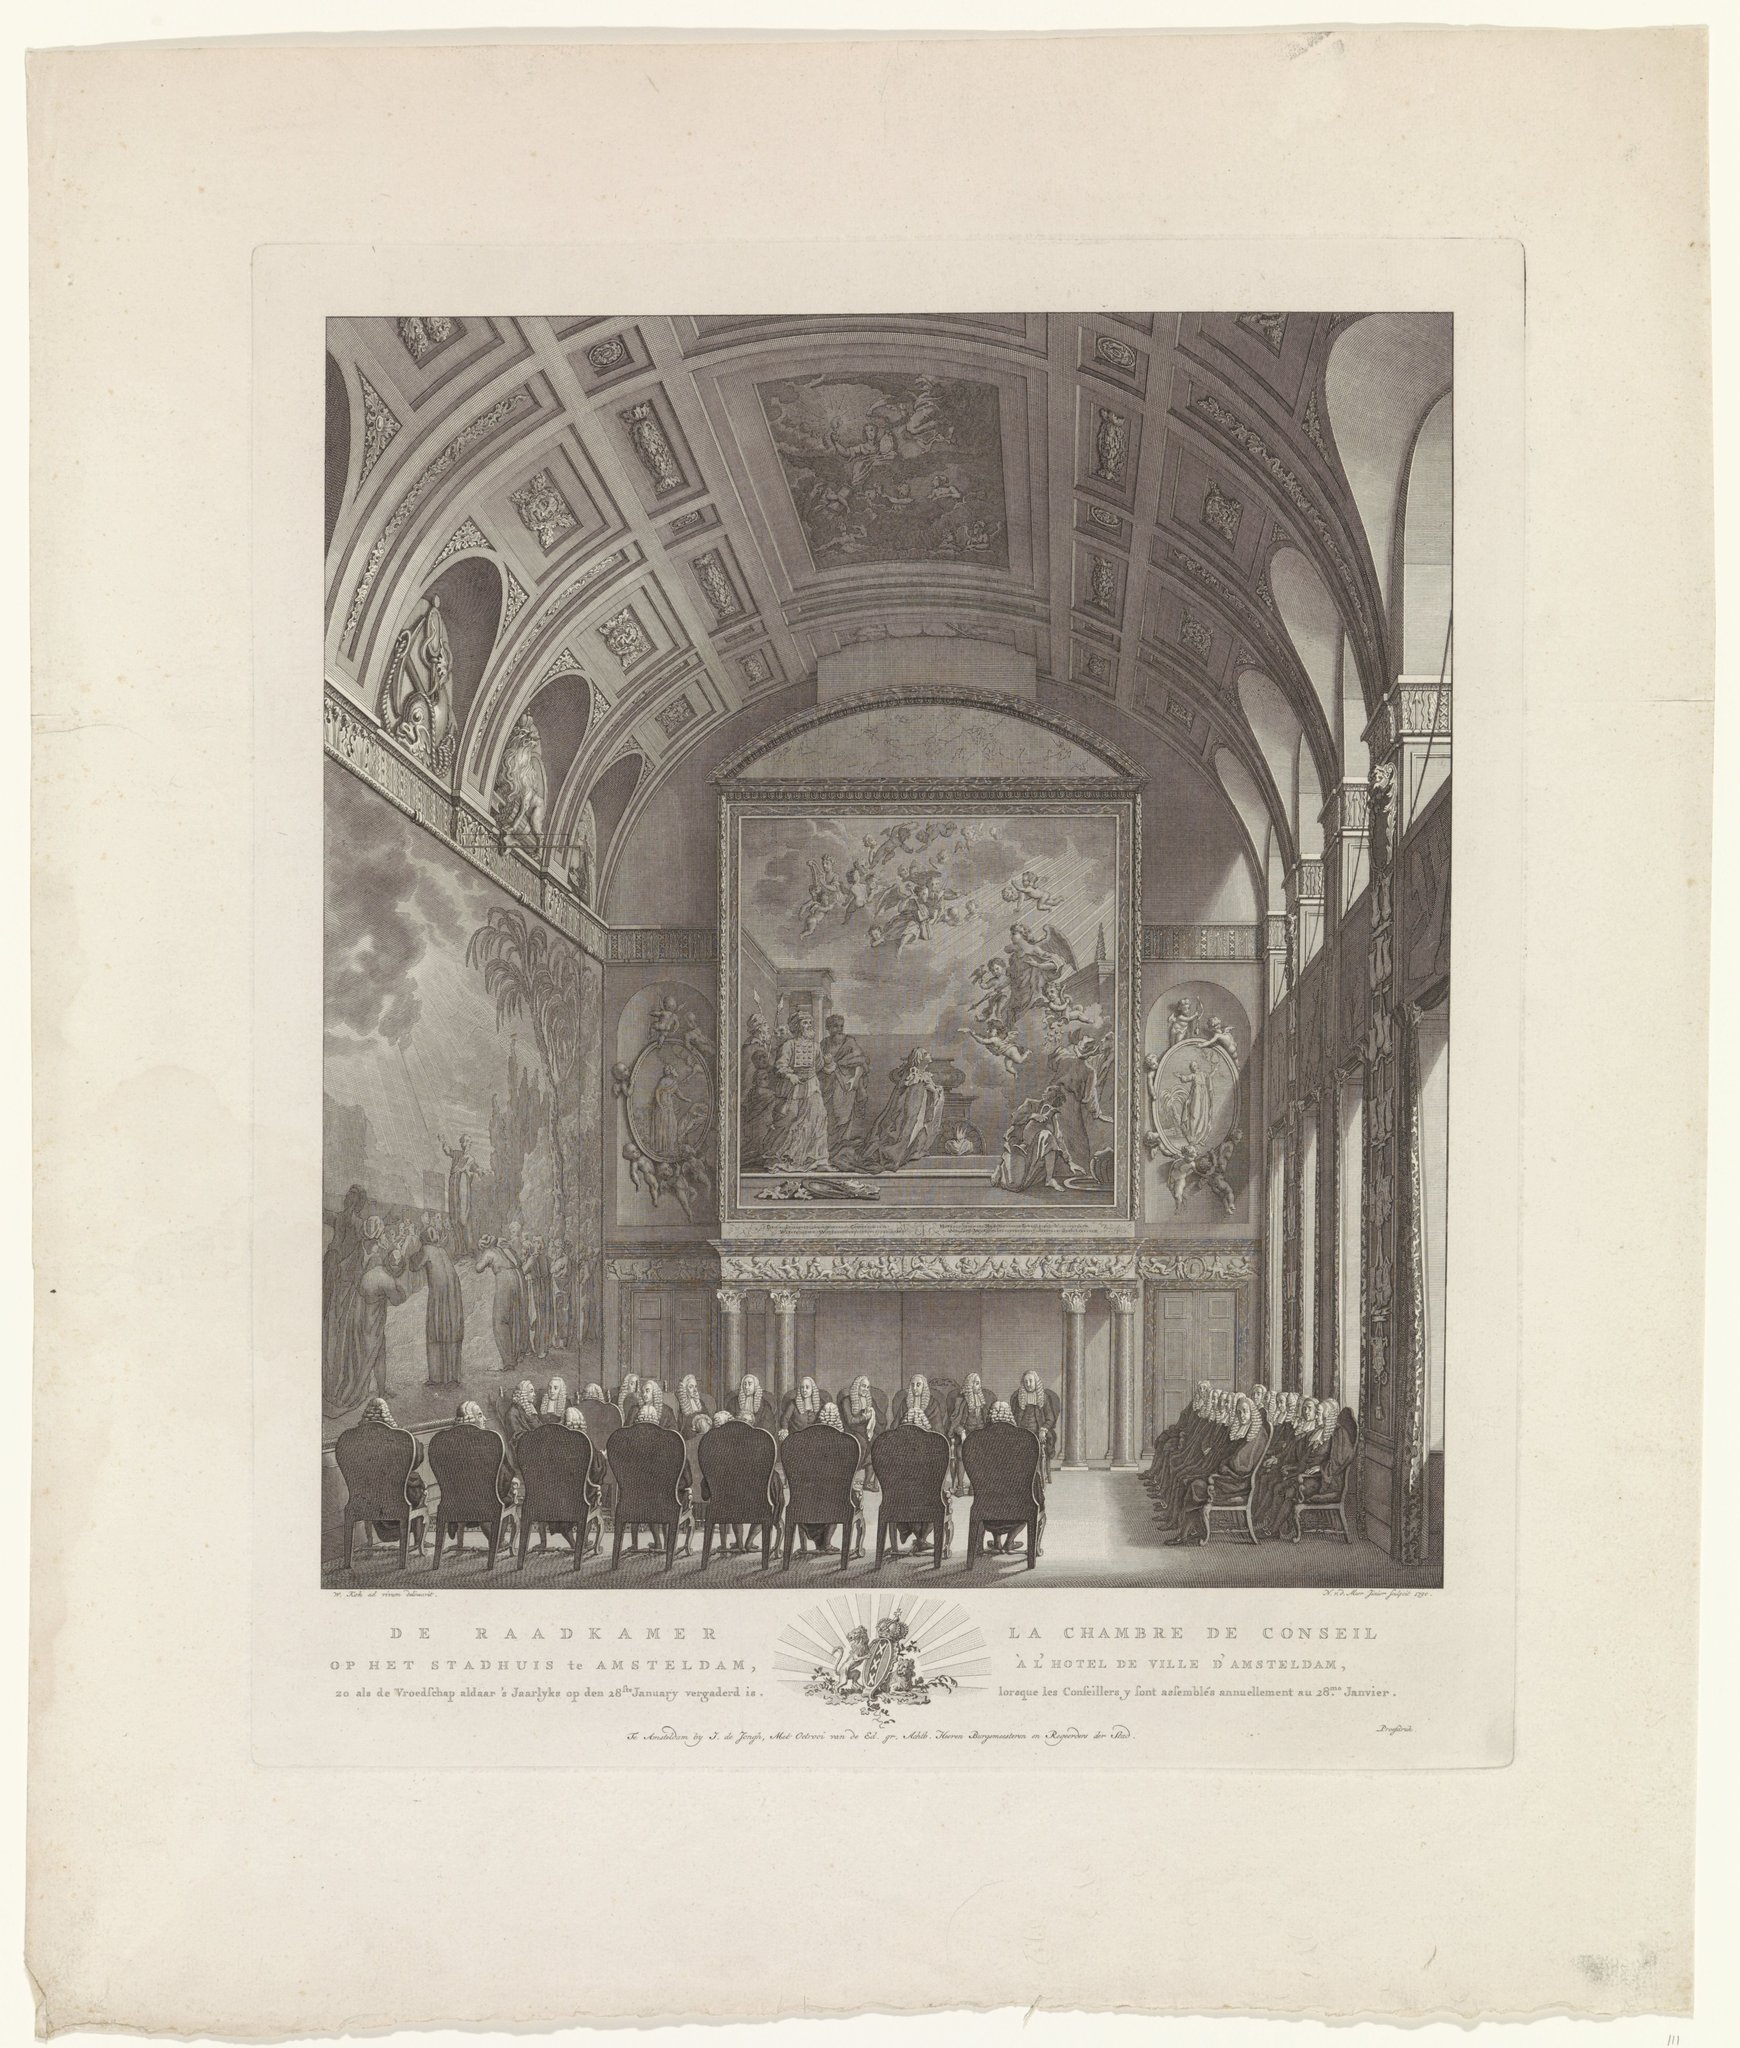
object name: print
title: De raadkamer op het stadhuis te Amsterdam (...)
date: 1790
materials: paper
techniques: engraving, etching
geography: amsterdam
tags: moses chooses seventy elders to assist him and places them round the tabernacle; the spirit of god descends upon them, city council, solomon's prayer for wisdom (1 kings 3:4-15)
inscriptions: collector's mark: Lugt 2228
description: Het interieur van de vroedschapskamer tijdens een vergadering van de vroedschap. Boven de schouw hangt het door Govert Flinck vervaardigde schilderij Salomo's gebed om wijsheid. Links het door Jacob de Wit vervaardigde schilderij De verkiezing van de zeventig oudsten door Mozes. Midden onder in de marge twee leeuwen bij het wapen van Amsterdam.